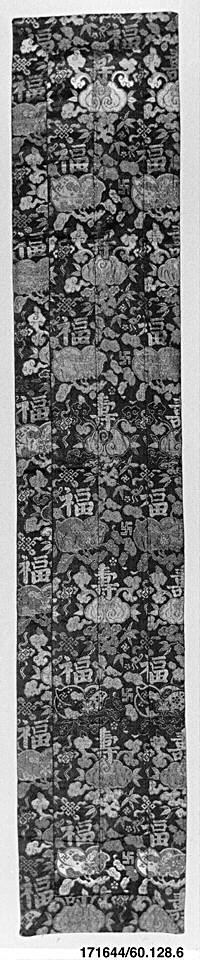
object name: stole, priest's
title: Priest's Stole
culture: japanese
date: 1701-1800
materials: metal thread, silk